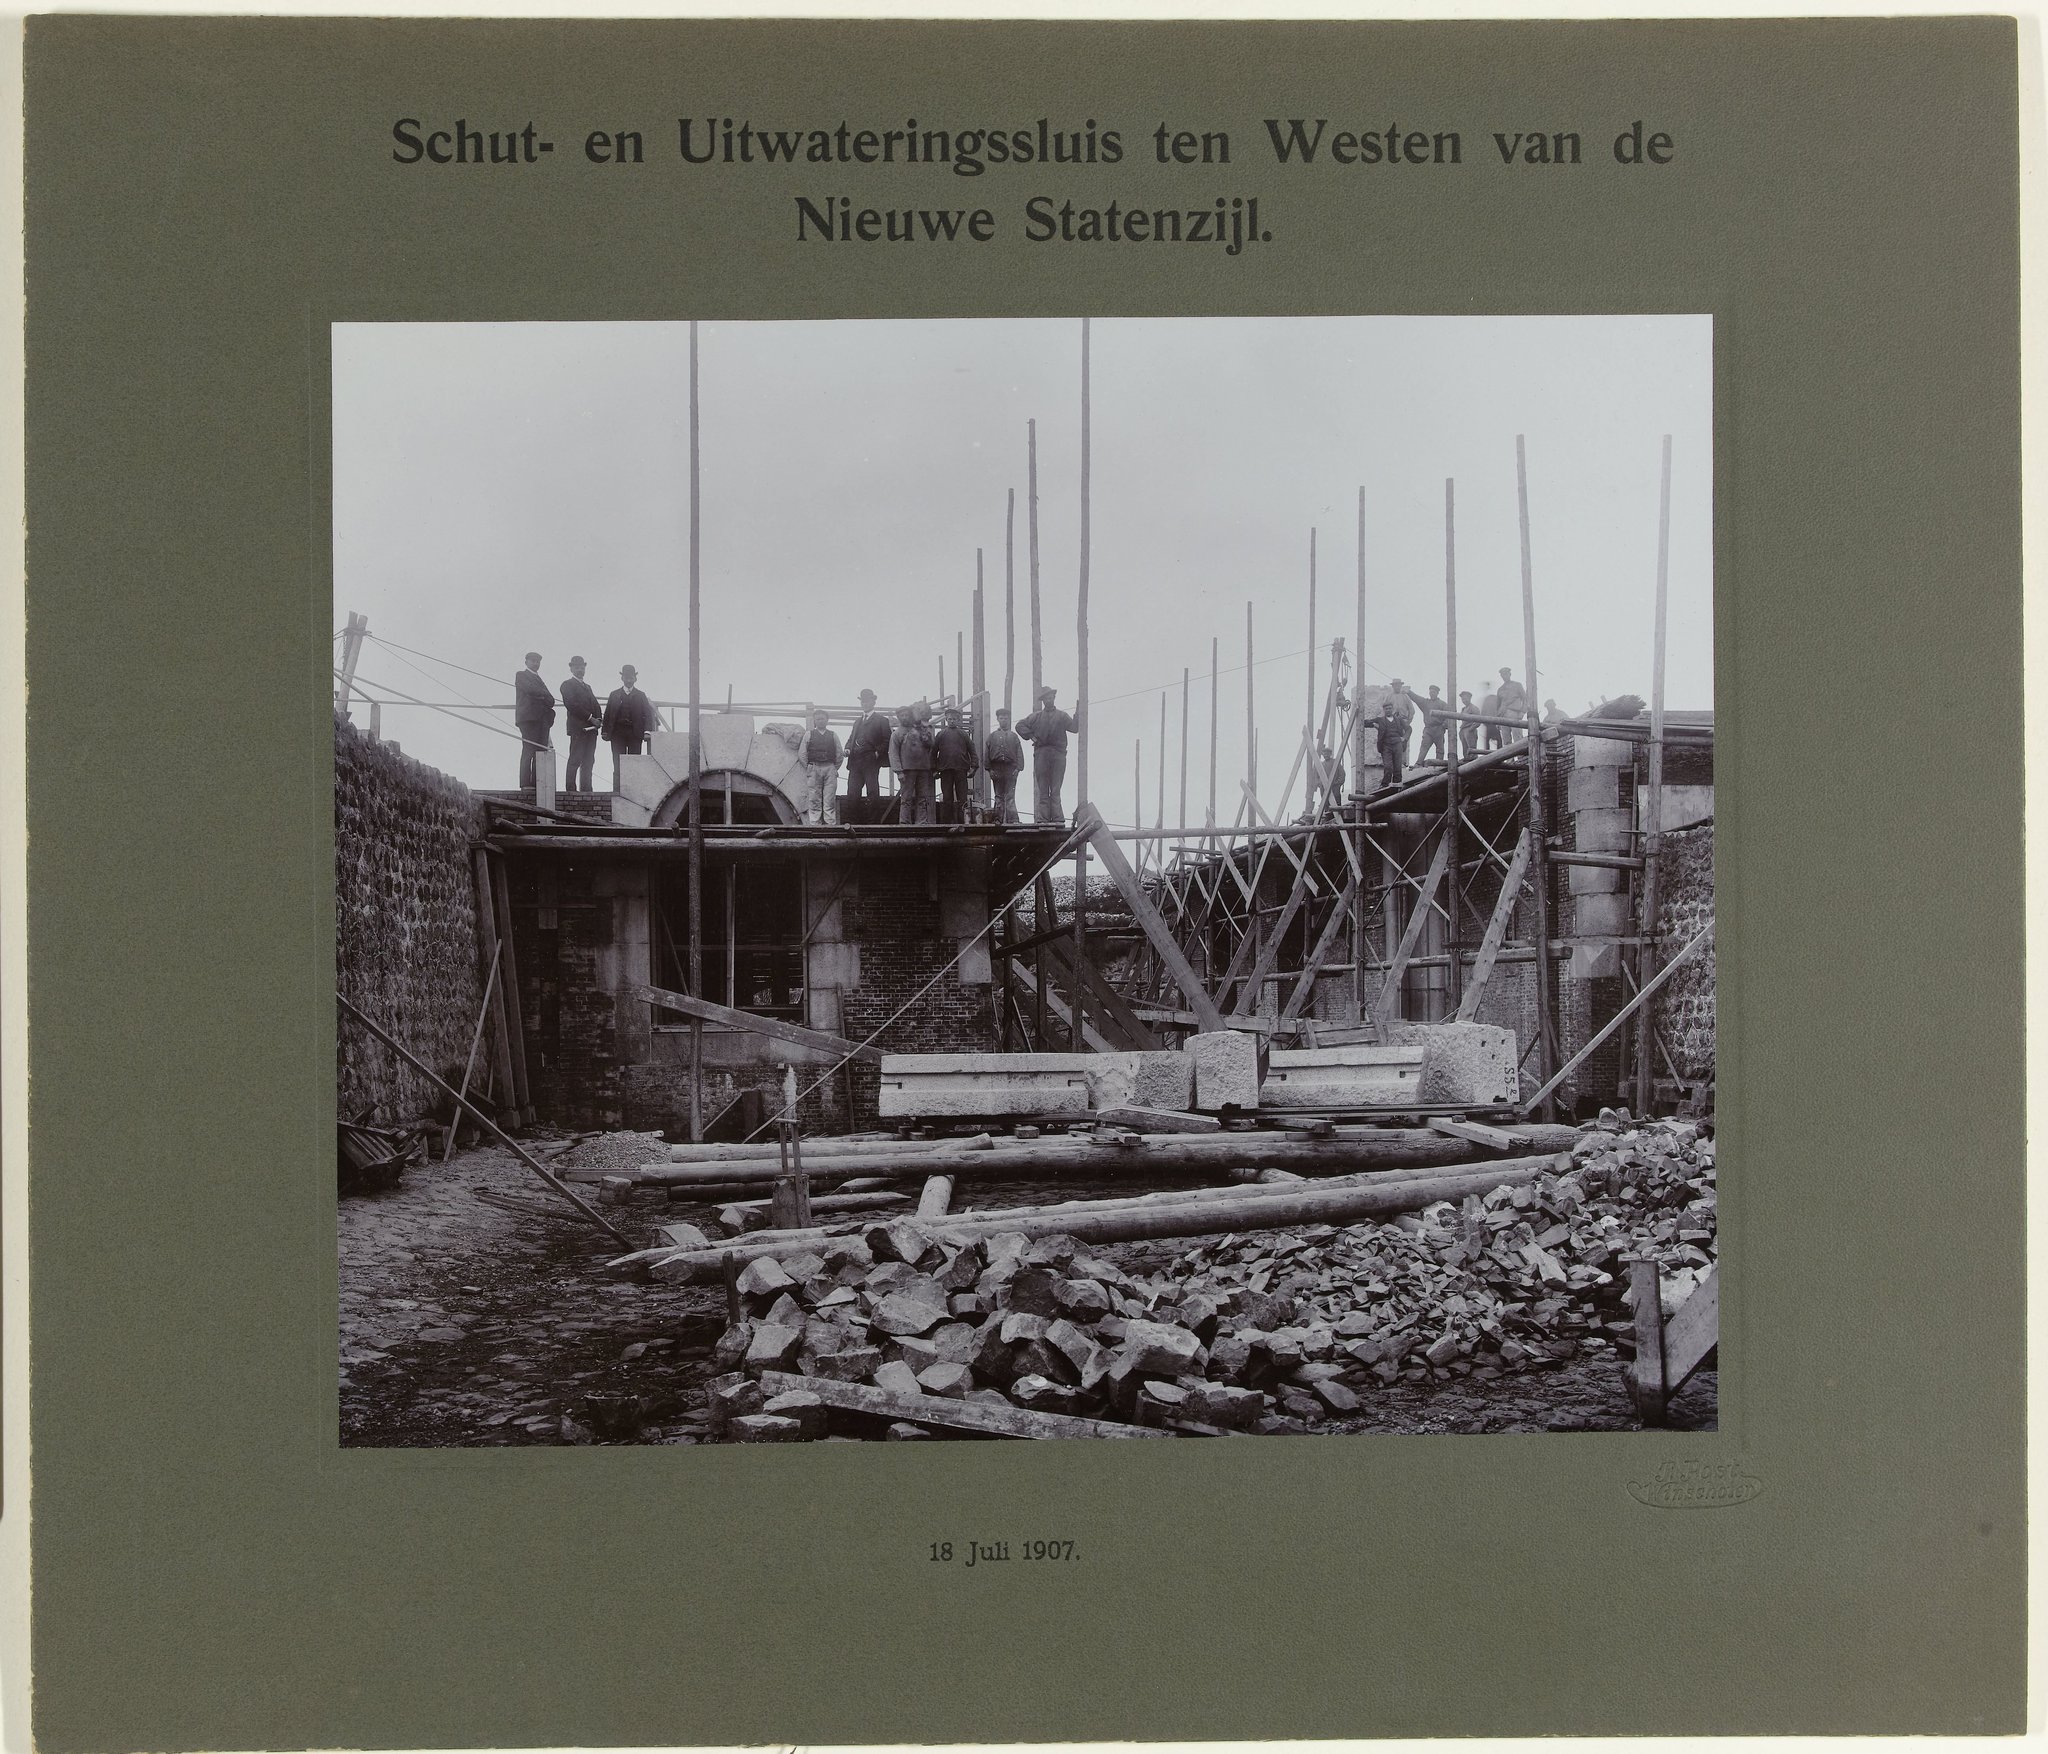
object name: photograph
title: Schut- en Uitwateringssluis ten Westen van de Nieuwe Statenzijl 1907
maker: tonnis post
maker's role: fotograaf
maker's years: 1877-1930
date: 1907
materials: cardboard, paper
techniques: photography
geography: winschoten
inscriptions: date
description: Een van 8 foto's in cassette aangaande een sluis (bij Nieuwe Statenzijl). Foto op blauwgrijs karton geplakt, cassette: paars / bruin. Gedateerd. Opmerking: zie NG-1976-36-B-1 t/m 8.